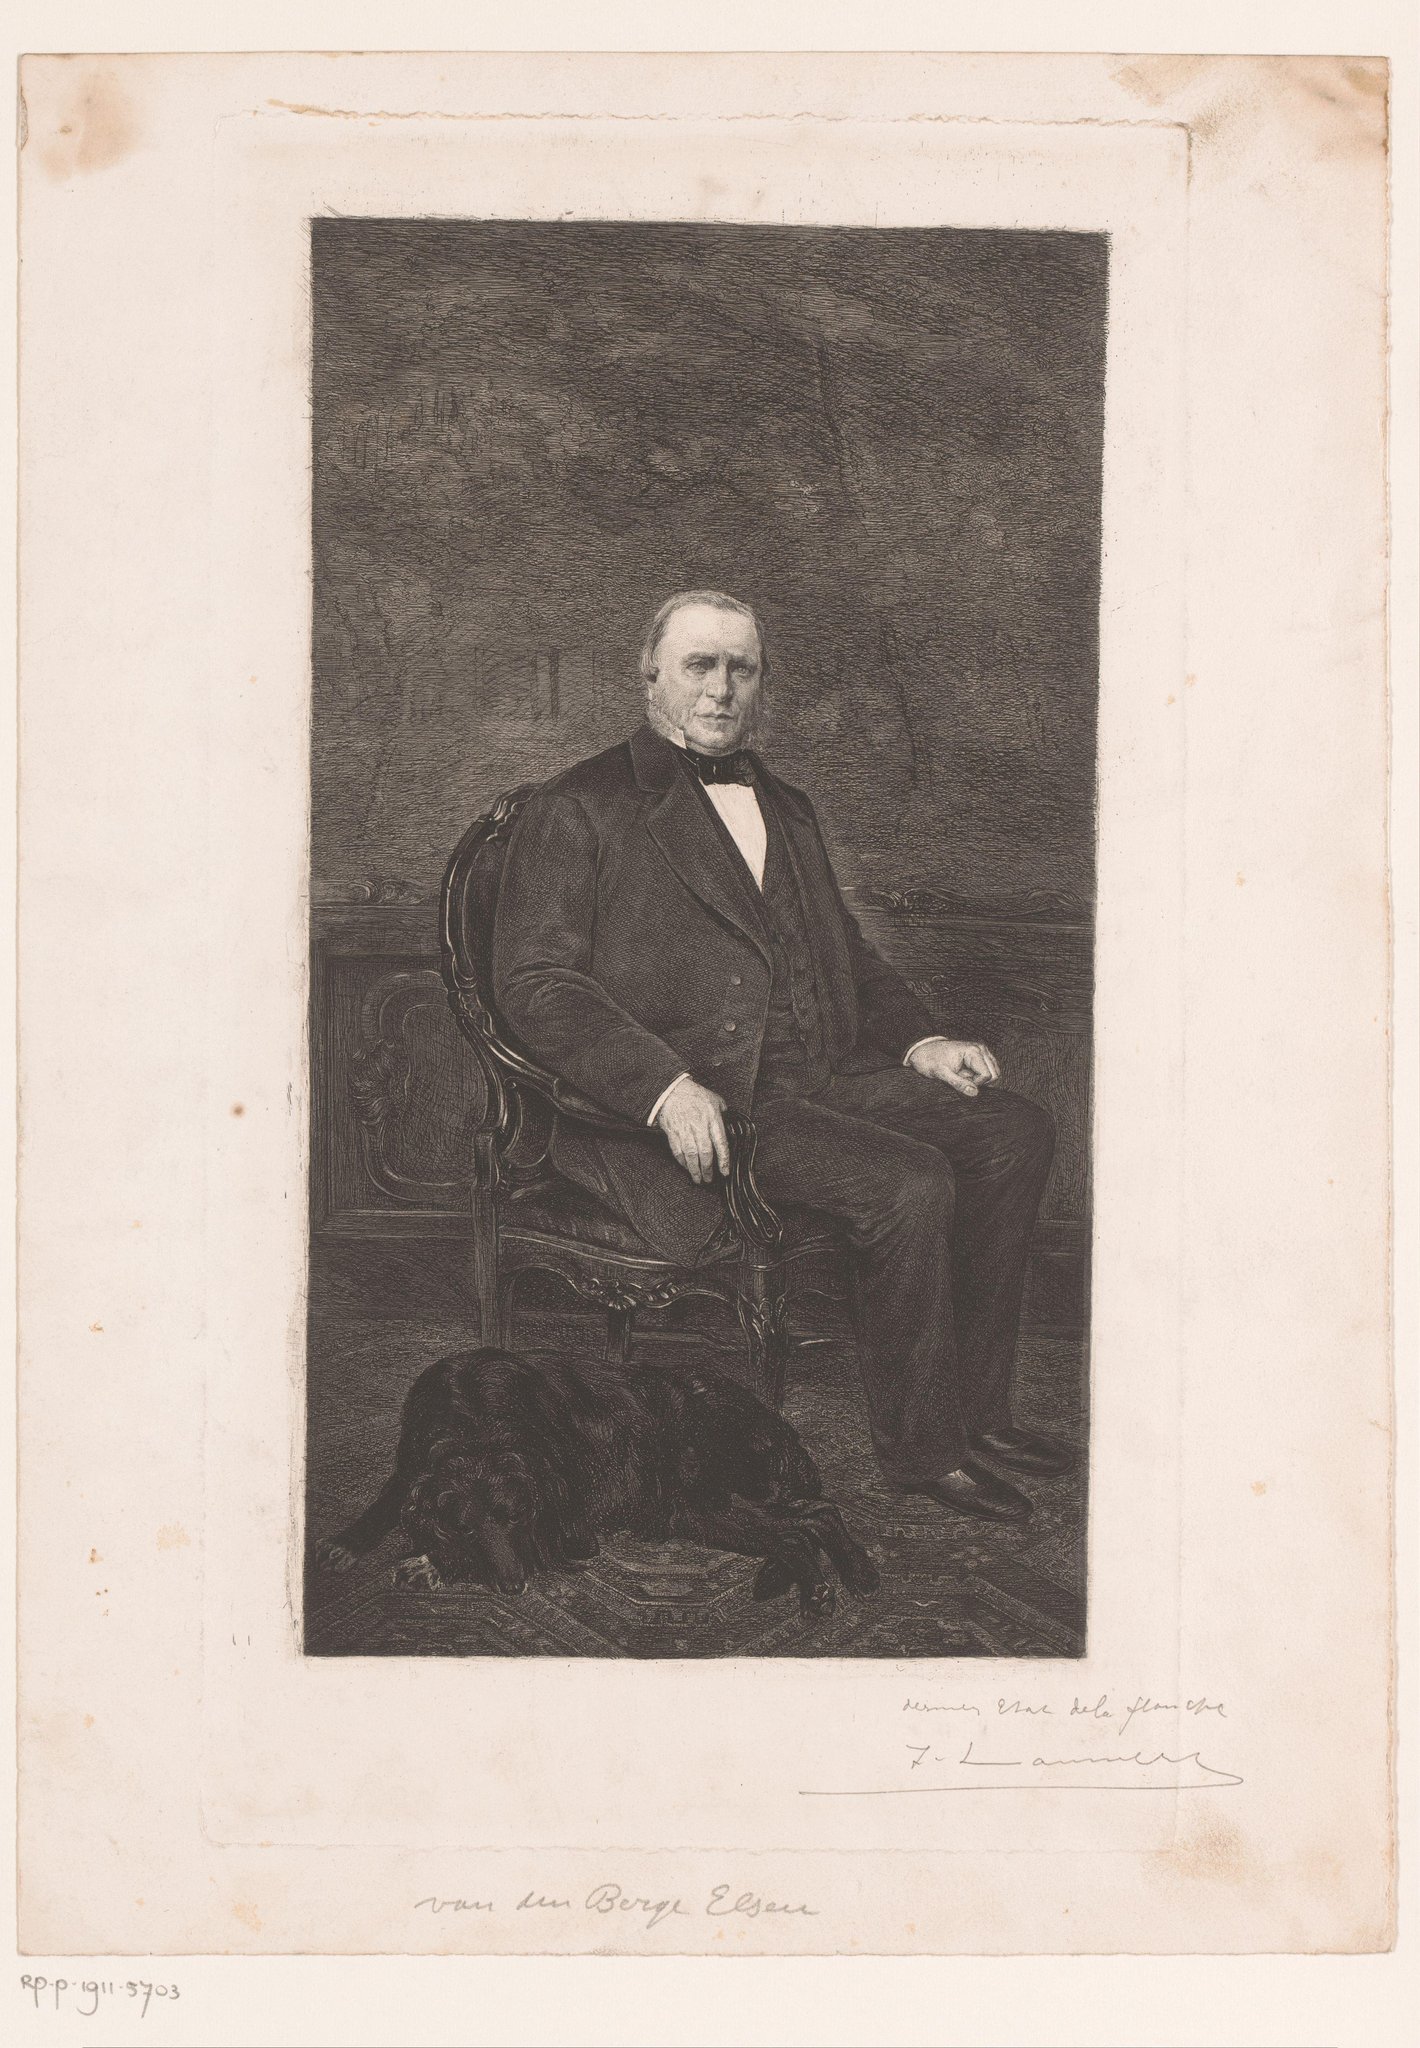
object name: print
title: Portret van een onbekende man, mogelijk senator Van den Berge Elsen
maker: frans lauwers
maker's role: print maker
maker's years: 1854-1931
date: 1864-1911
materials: paper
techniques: etching, intaglio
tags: historical persons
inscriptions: collector's mark: Lugt 2228, annotation: ‘dernier état de la planche’